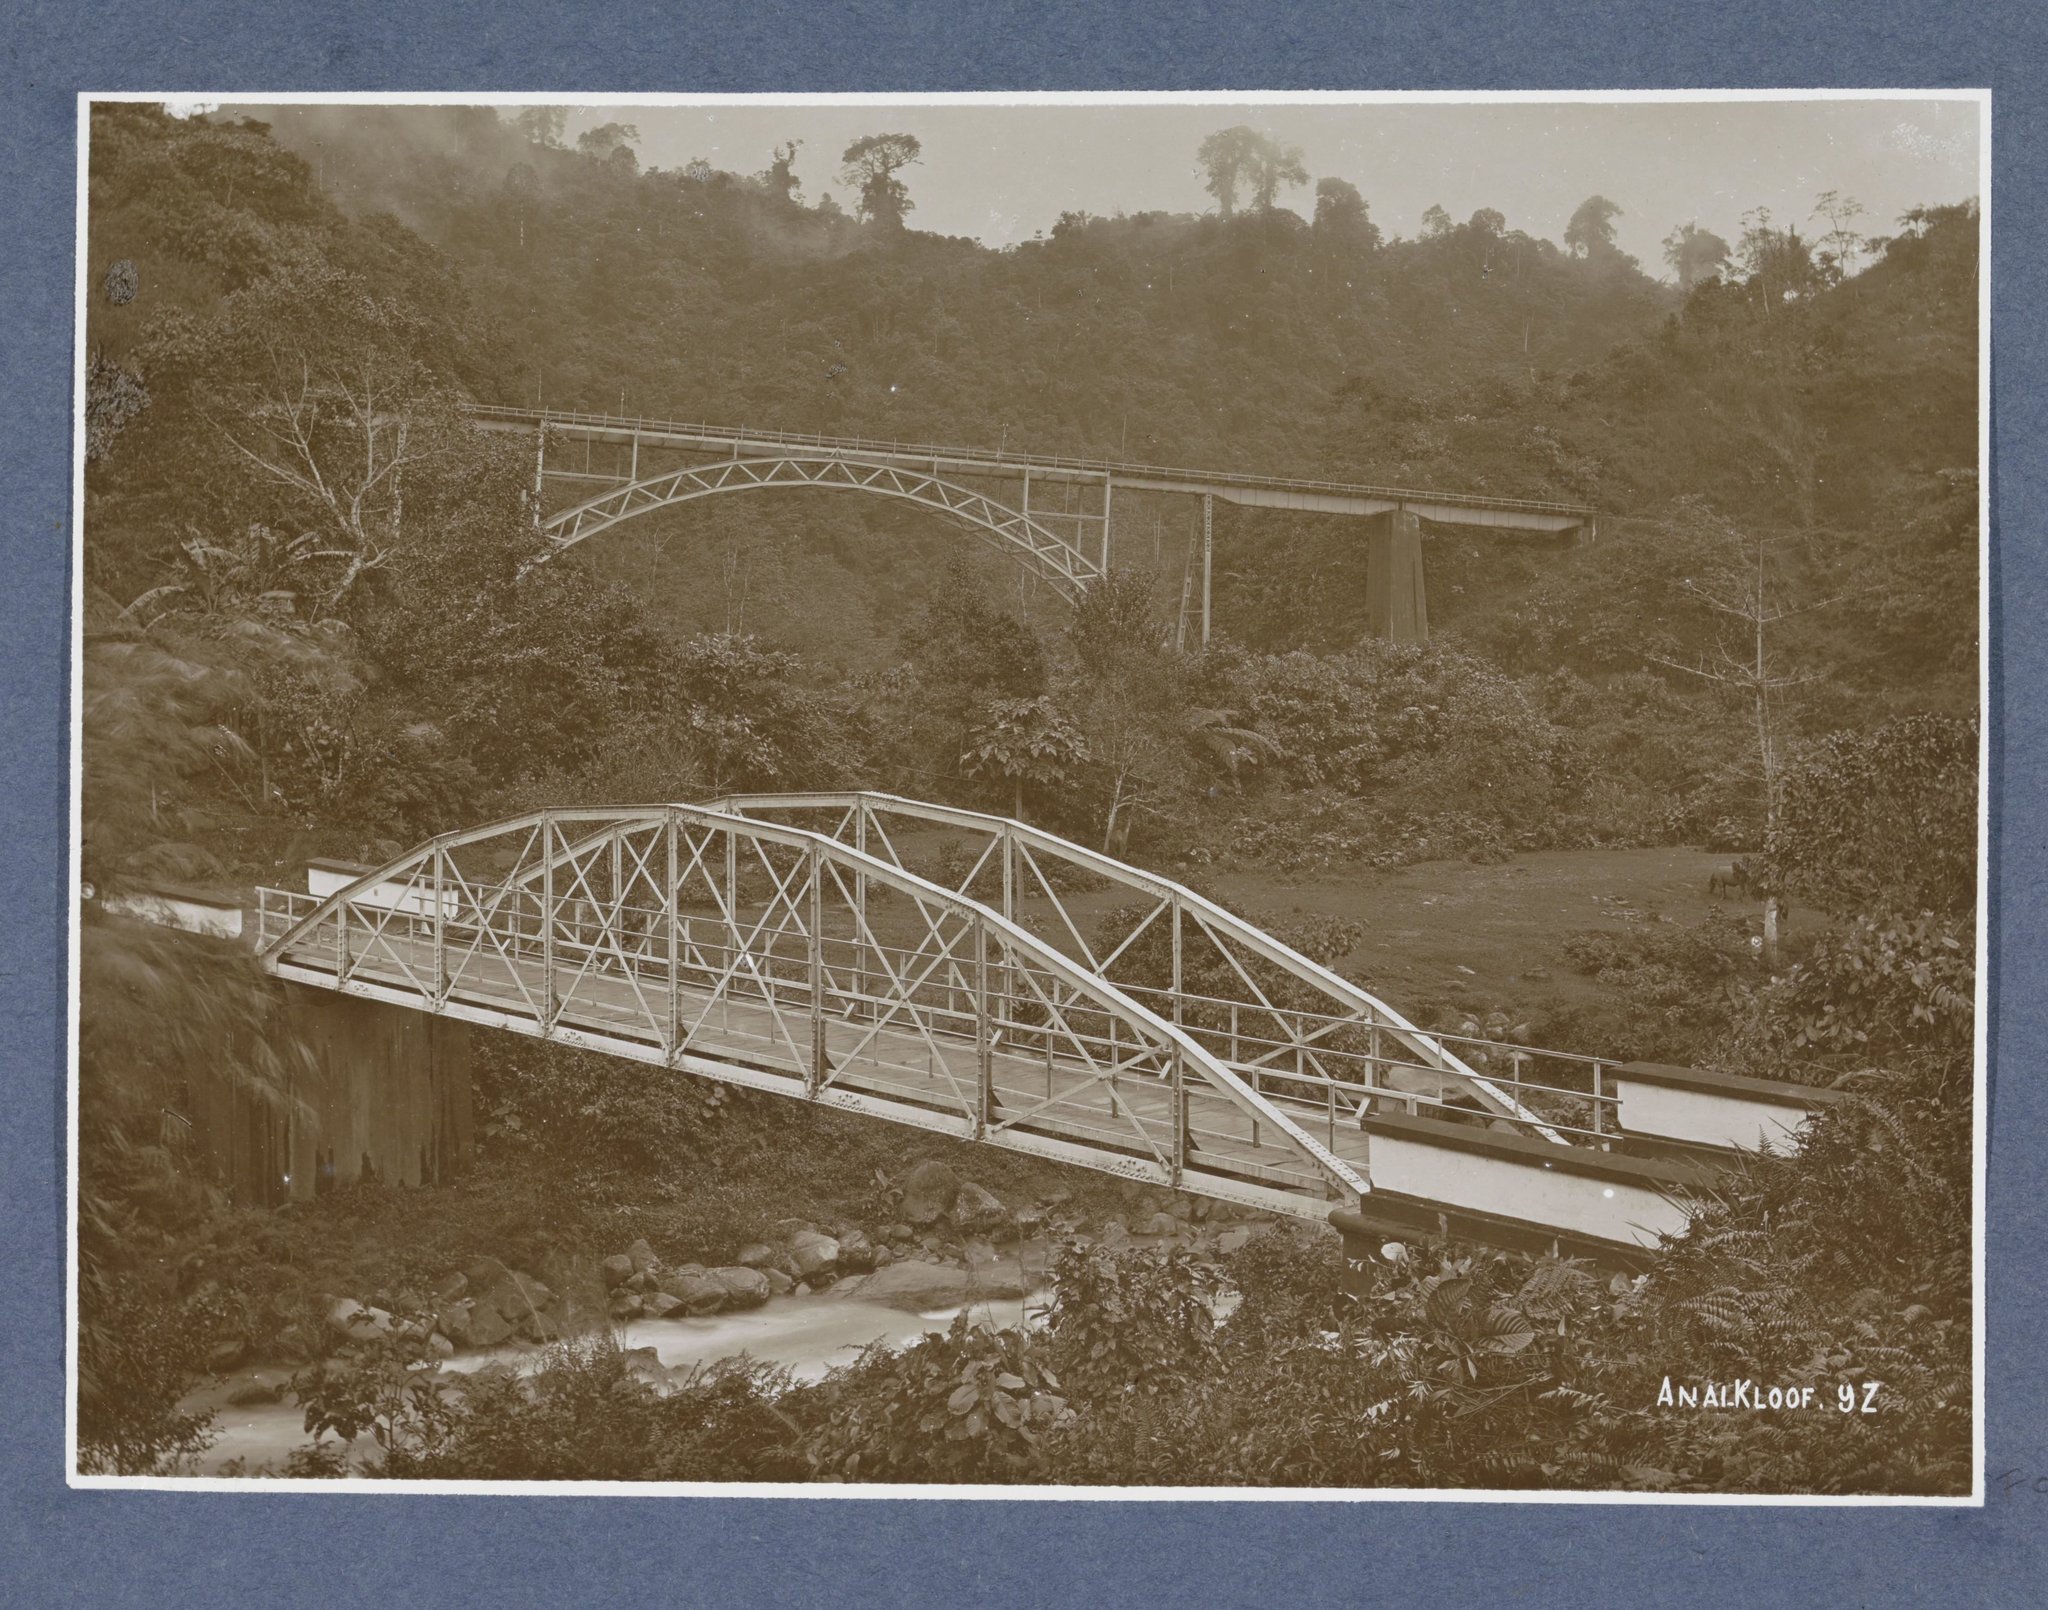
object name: album leaf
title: Bruggen in de Anaikloof op Sumatra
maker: christiaan benjamin nieuwenhuis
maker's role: publisher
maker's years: 1863-1922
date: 1900-1920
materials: paper, photographic support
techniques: gelatin silver print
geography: sumatra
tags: landscape with bridge, viaduct or aqueduct, ravine, chasm, abyss, canyon, railway, train, sumatra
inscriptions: number: ‘9Z’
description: Onderdeel van reisalbum met foto's van bedrijvigheid en bezienswaardigheden op Sumatra en Java en van de reis naar en van Nederlands-Indië.